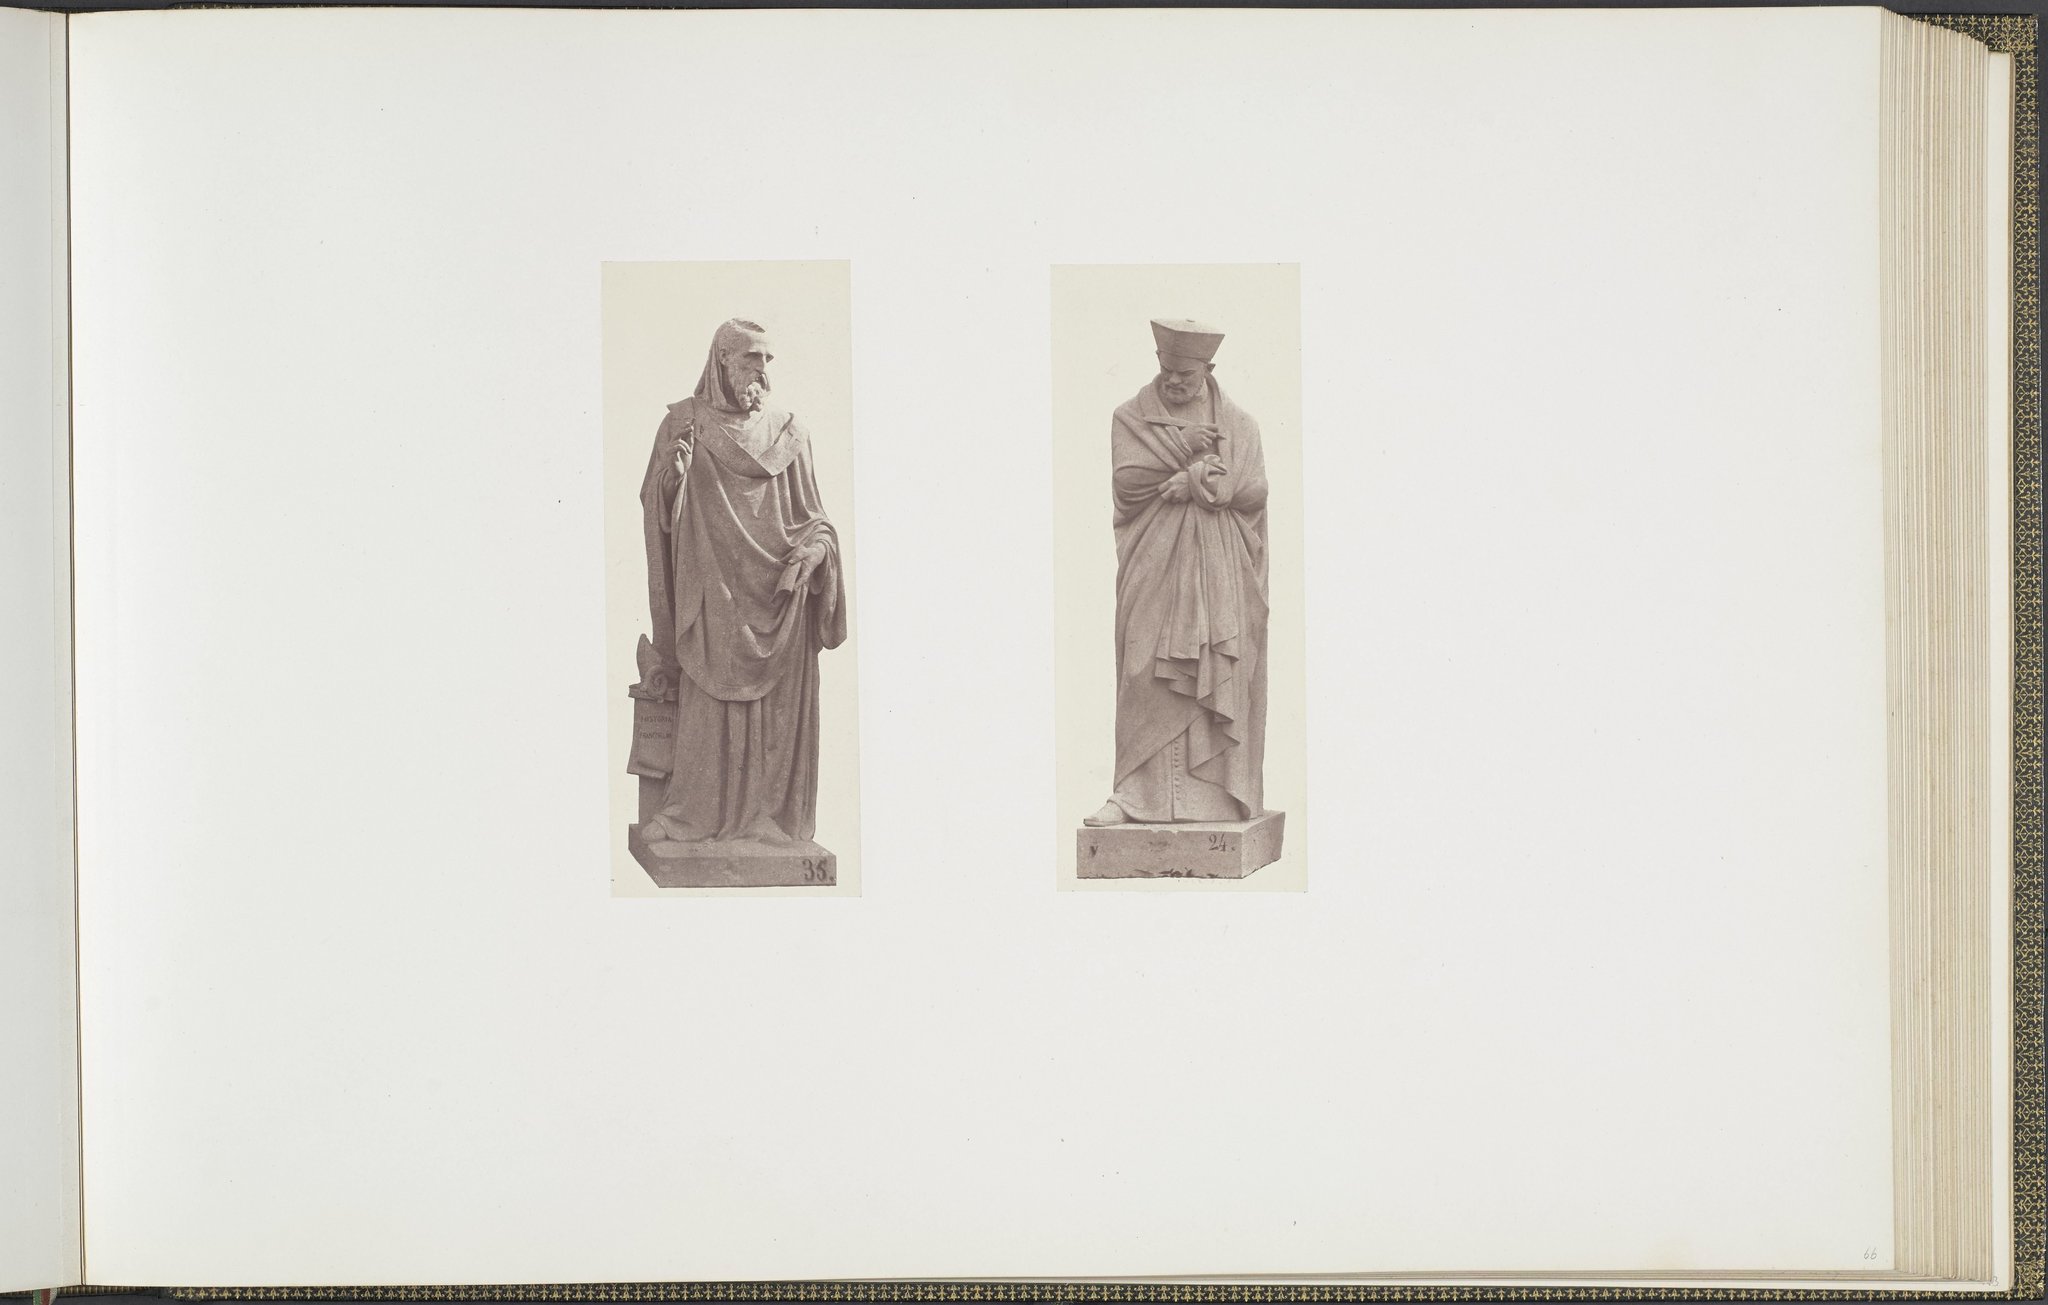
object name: album leaf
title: Gipsmodellen voor beeldhouwwerken op het Palais du Louvre: links "Saint Grégoire de Tours" door Jean-Esprit Marcellin en rechts "Rabelais" door Elias Robert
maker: édouard denis baldus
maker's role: fotograaf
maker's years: 1813-1889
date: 1855-1857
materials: paper, photographic support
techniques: salted paper print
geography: paris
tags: piece of sculpture, reproduction of a piece of sculpture, permanent exhibition, museum, paris, tuileries palace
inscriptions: number: ‘35 en 24’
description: Onderdeel van Réunion des Tuileries au Louvre 1852-1857, album 1.